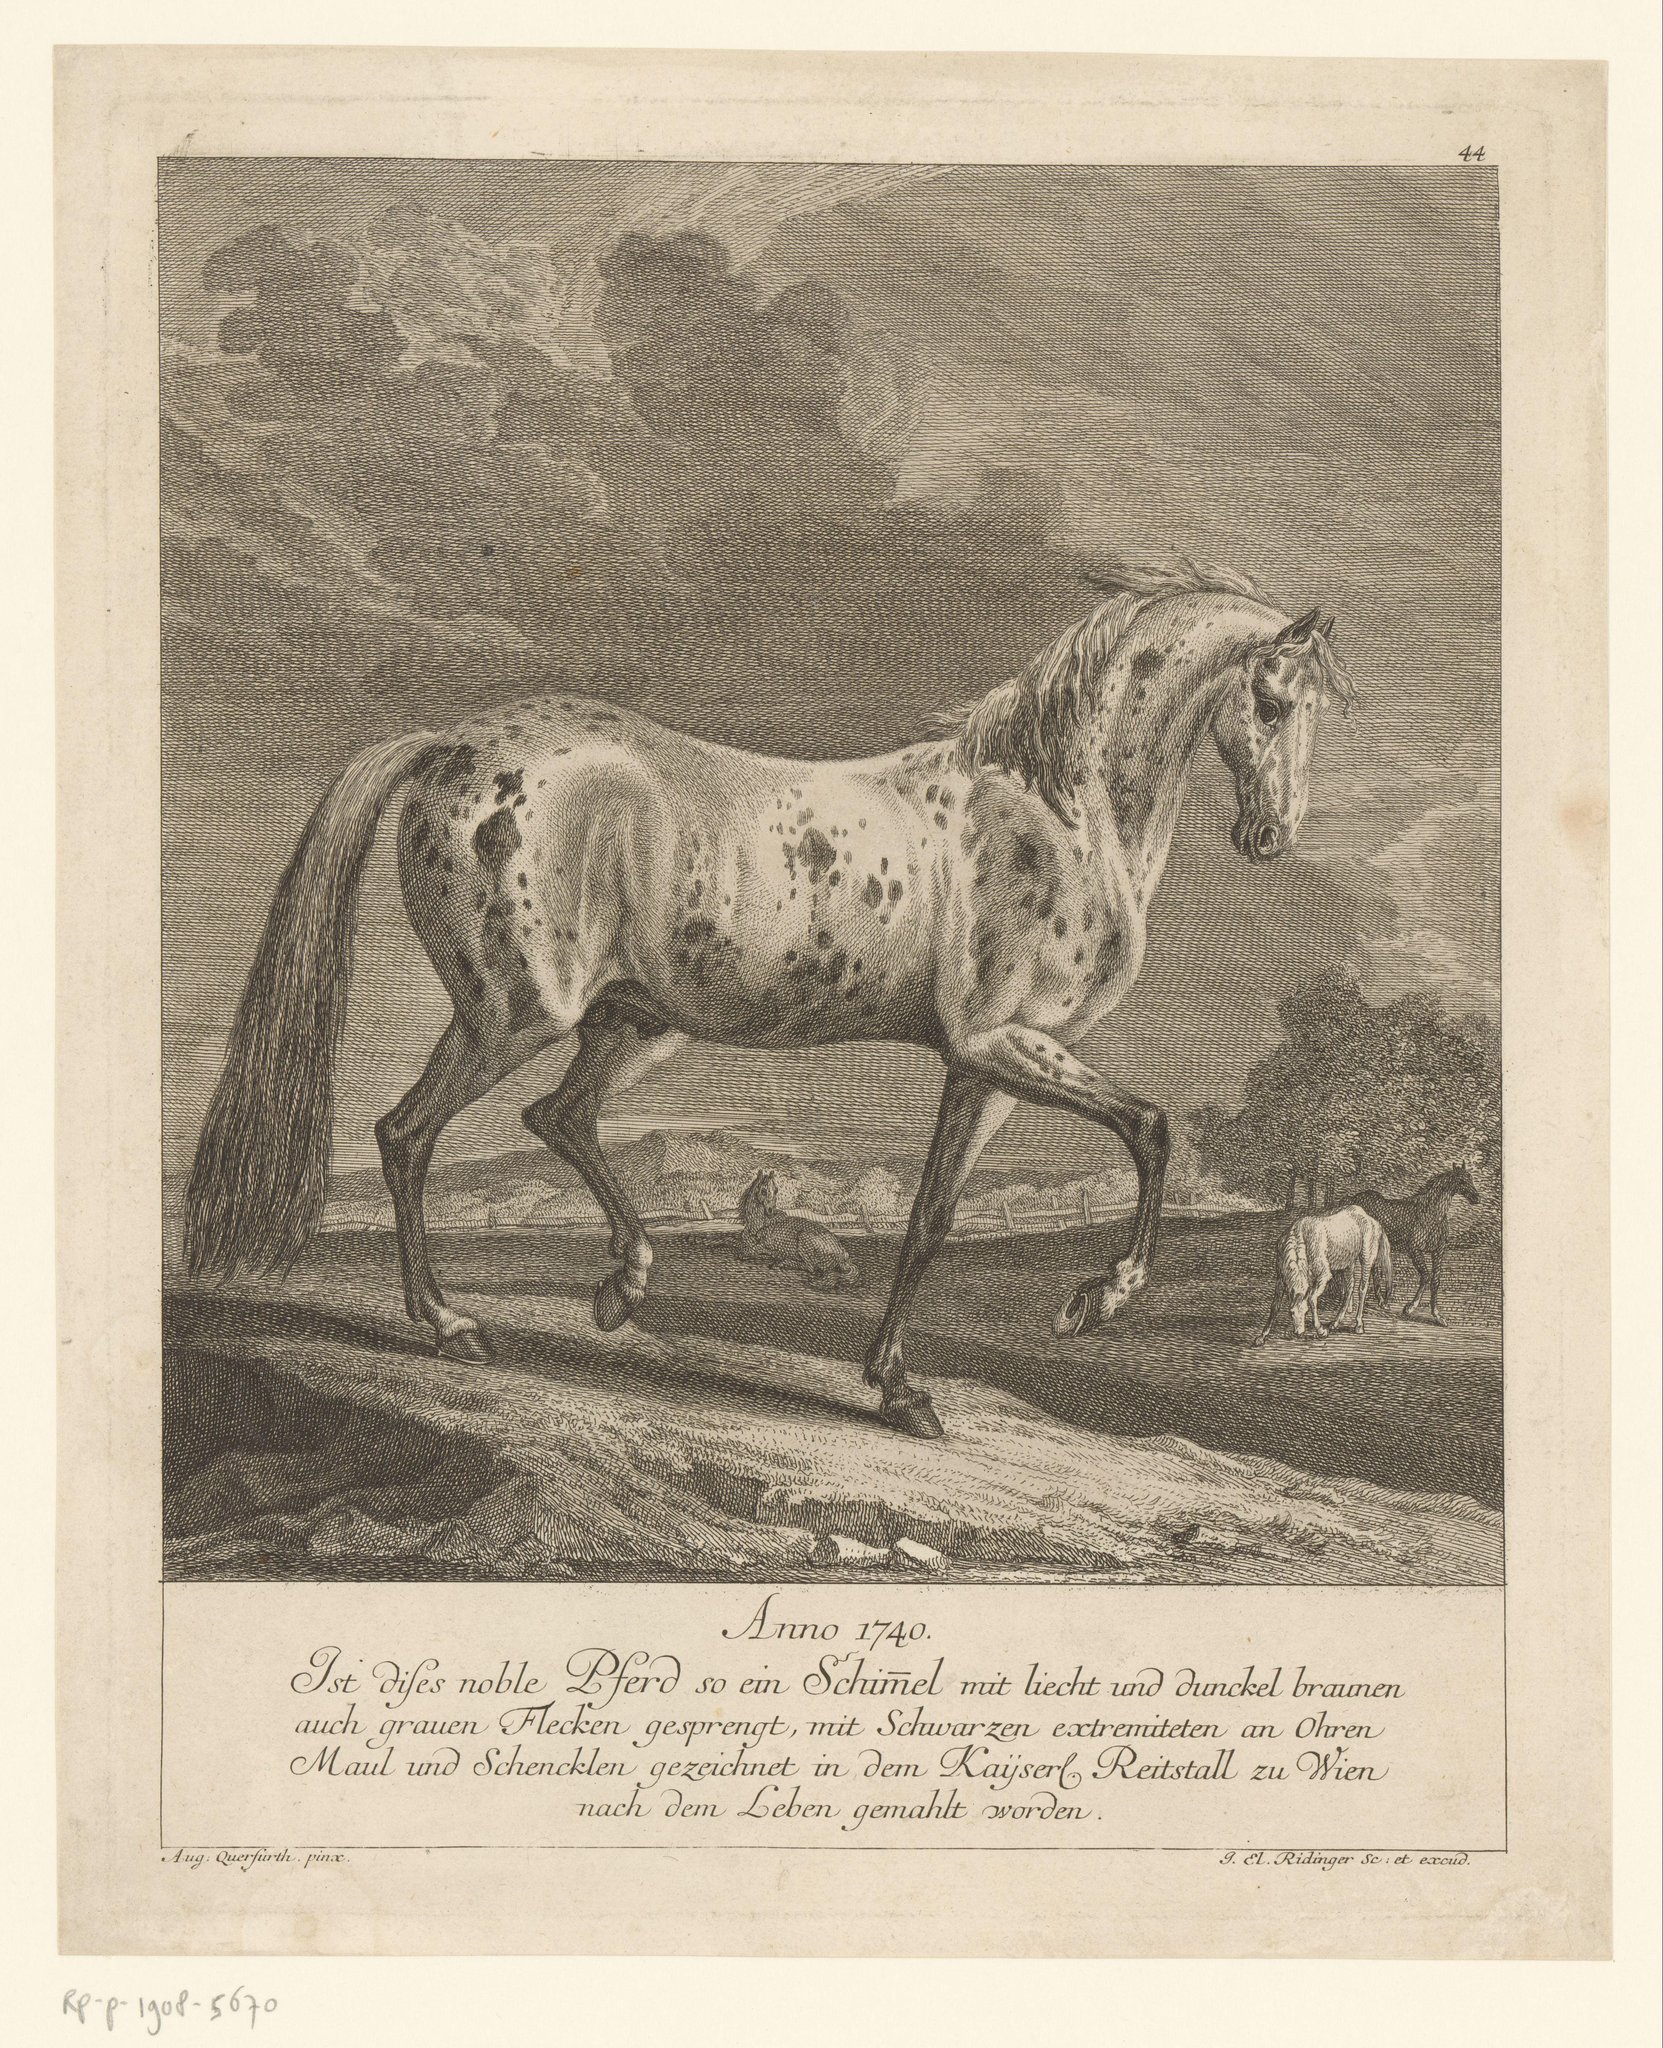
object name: print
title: De 100 meest wonderlijke herten en andere dieren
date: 1740-1780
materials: paper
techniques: etching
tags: horse, vienna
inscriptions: collector's mark: Lugt 2228